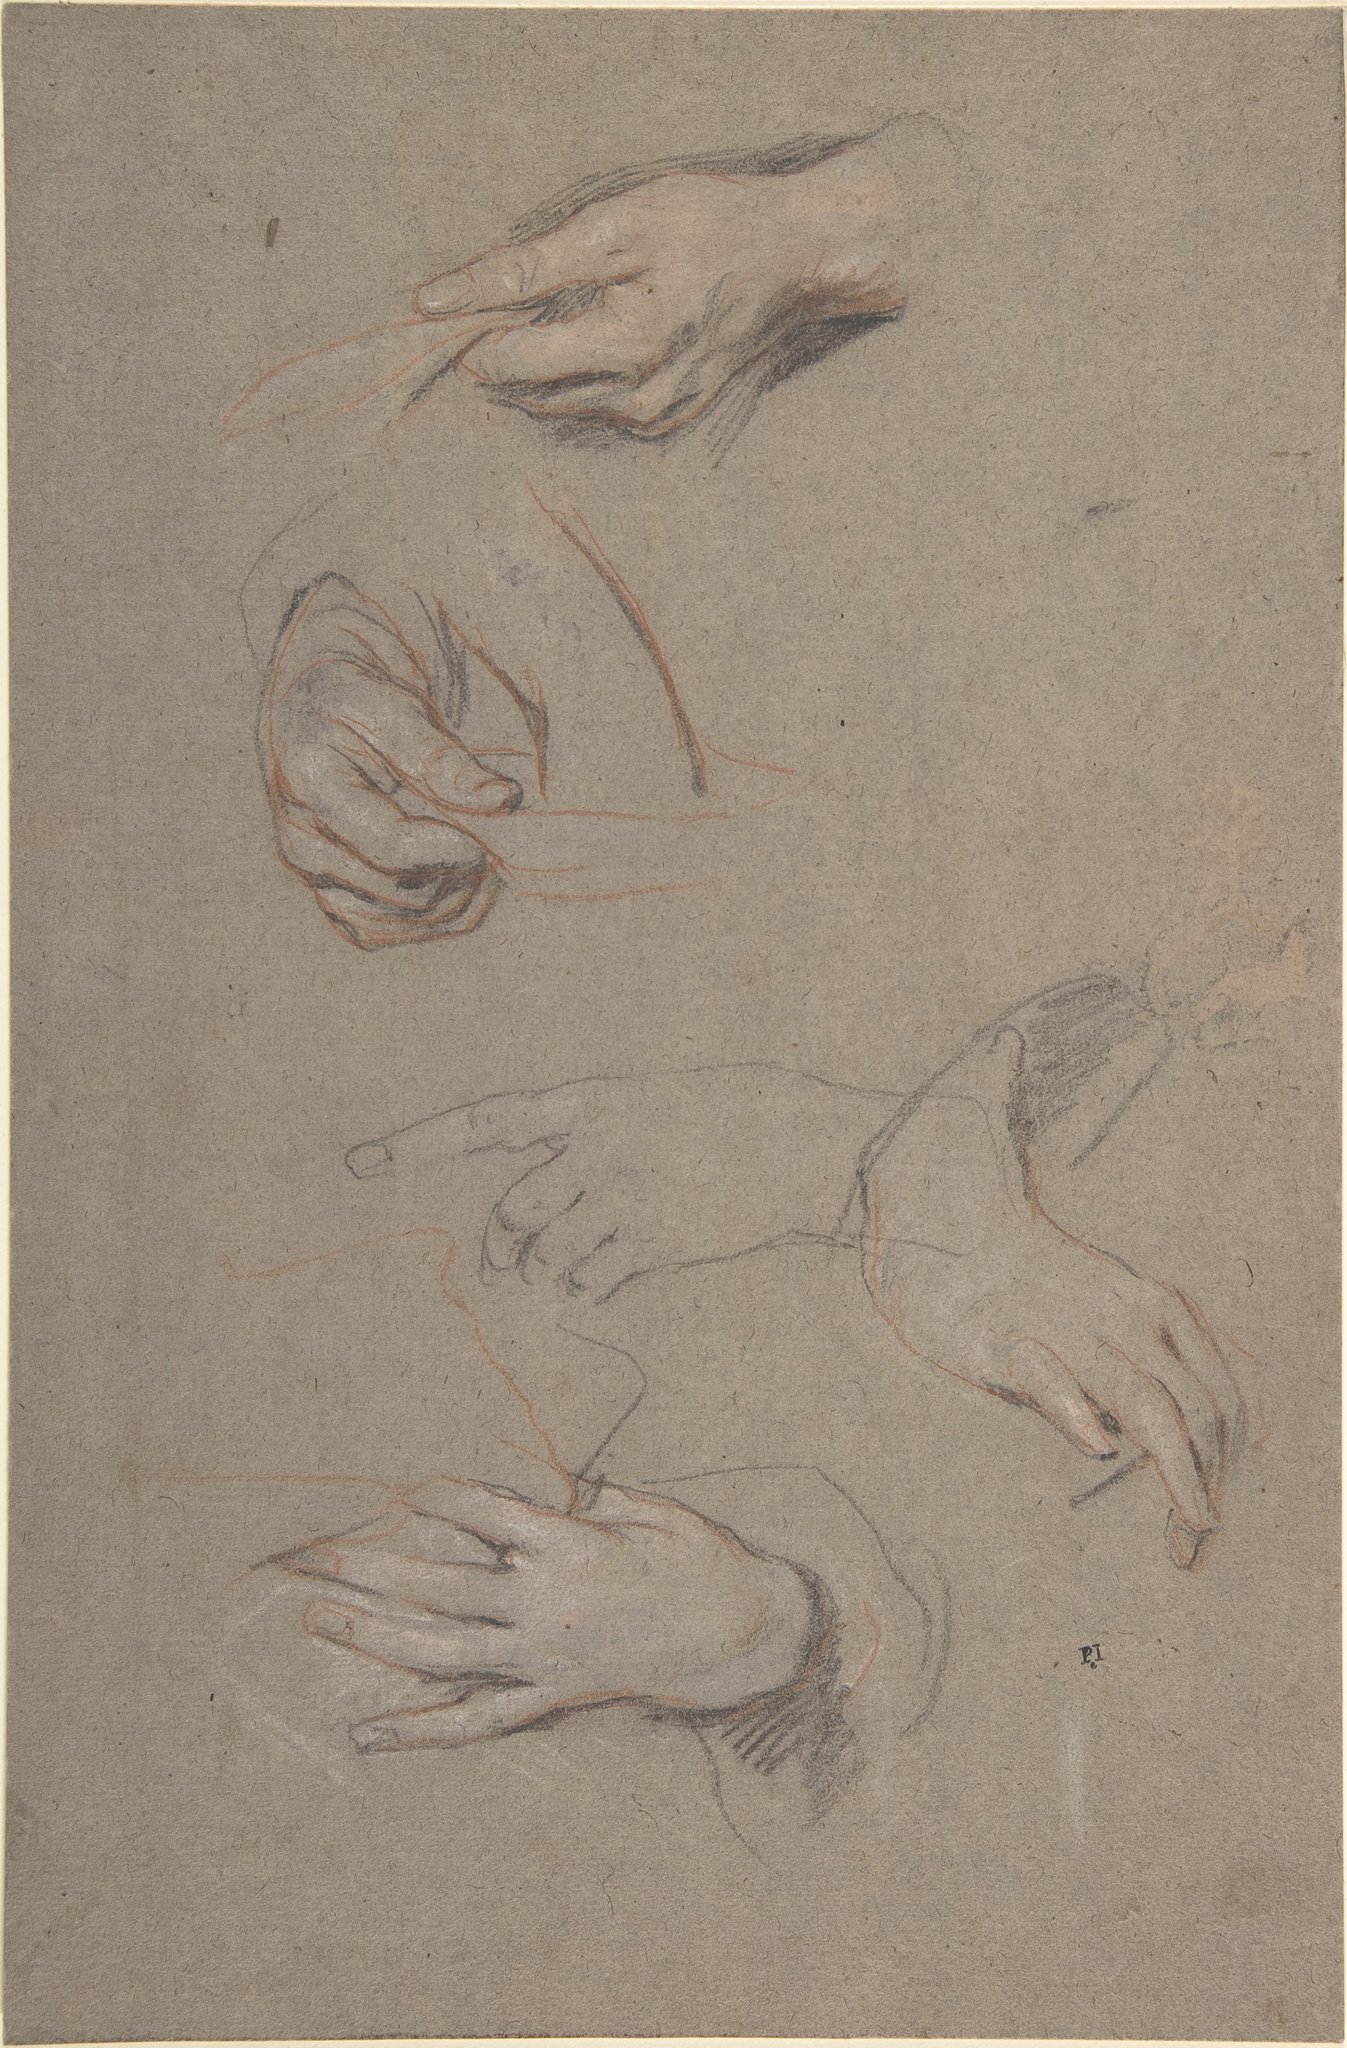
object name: drawing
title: Studies of Hands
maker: peter lely (sir)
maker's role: artist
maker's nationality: dutch, british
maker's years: 1618-1680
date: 1630-1680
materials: chalk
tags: hands